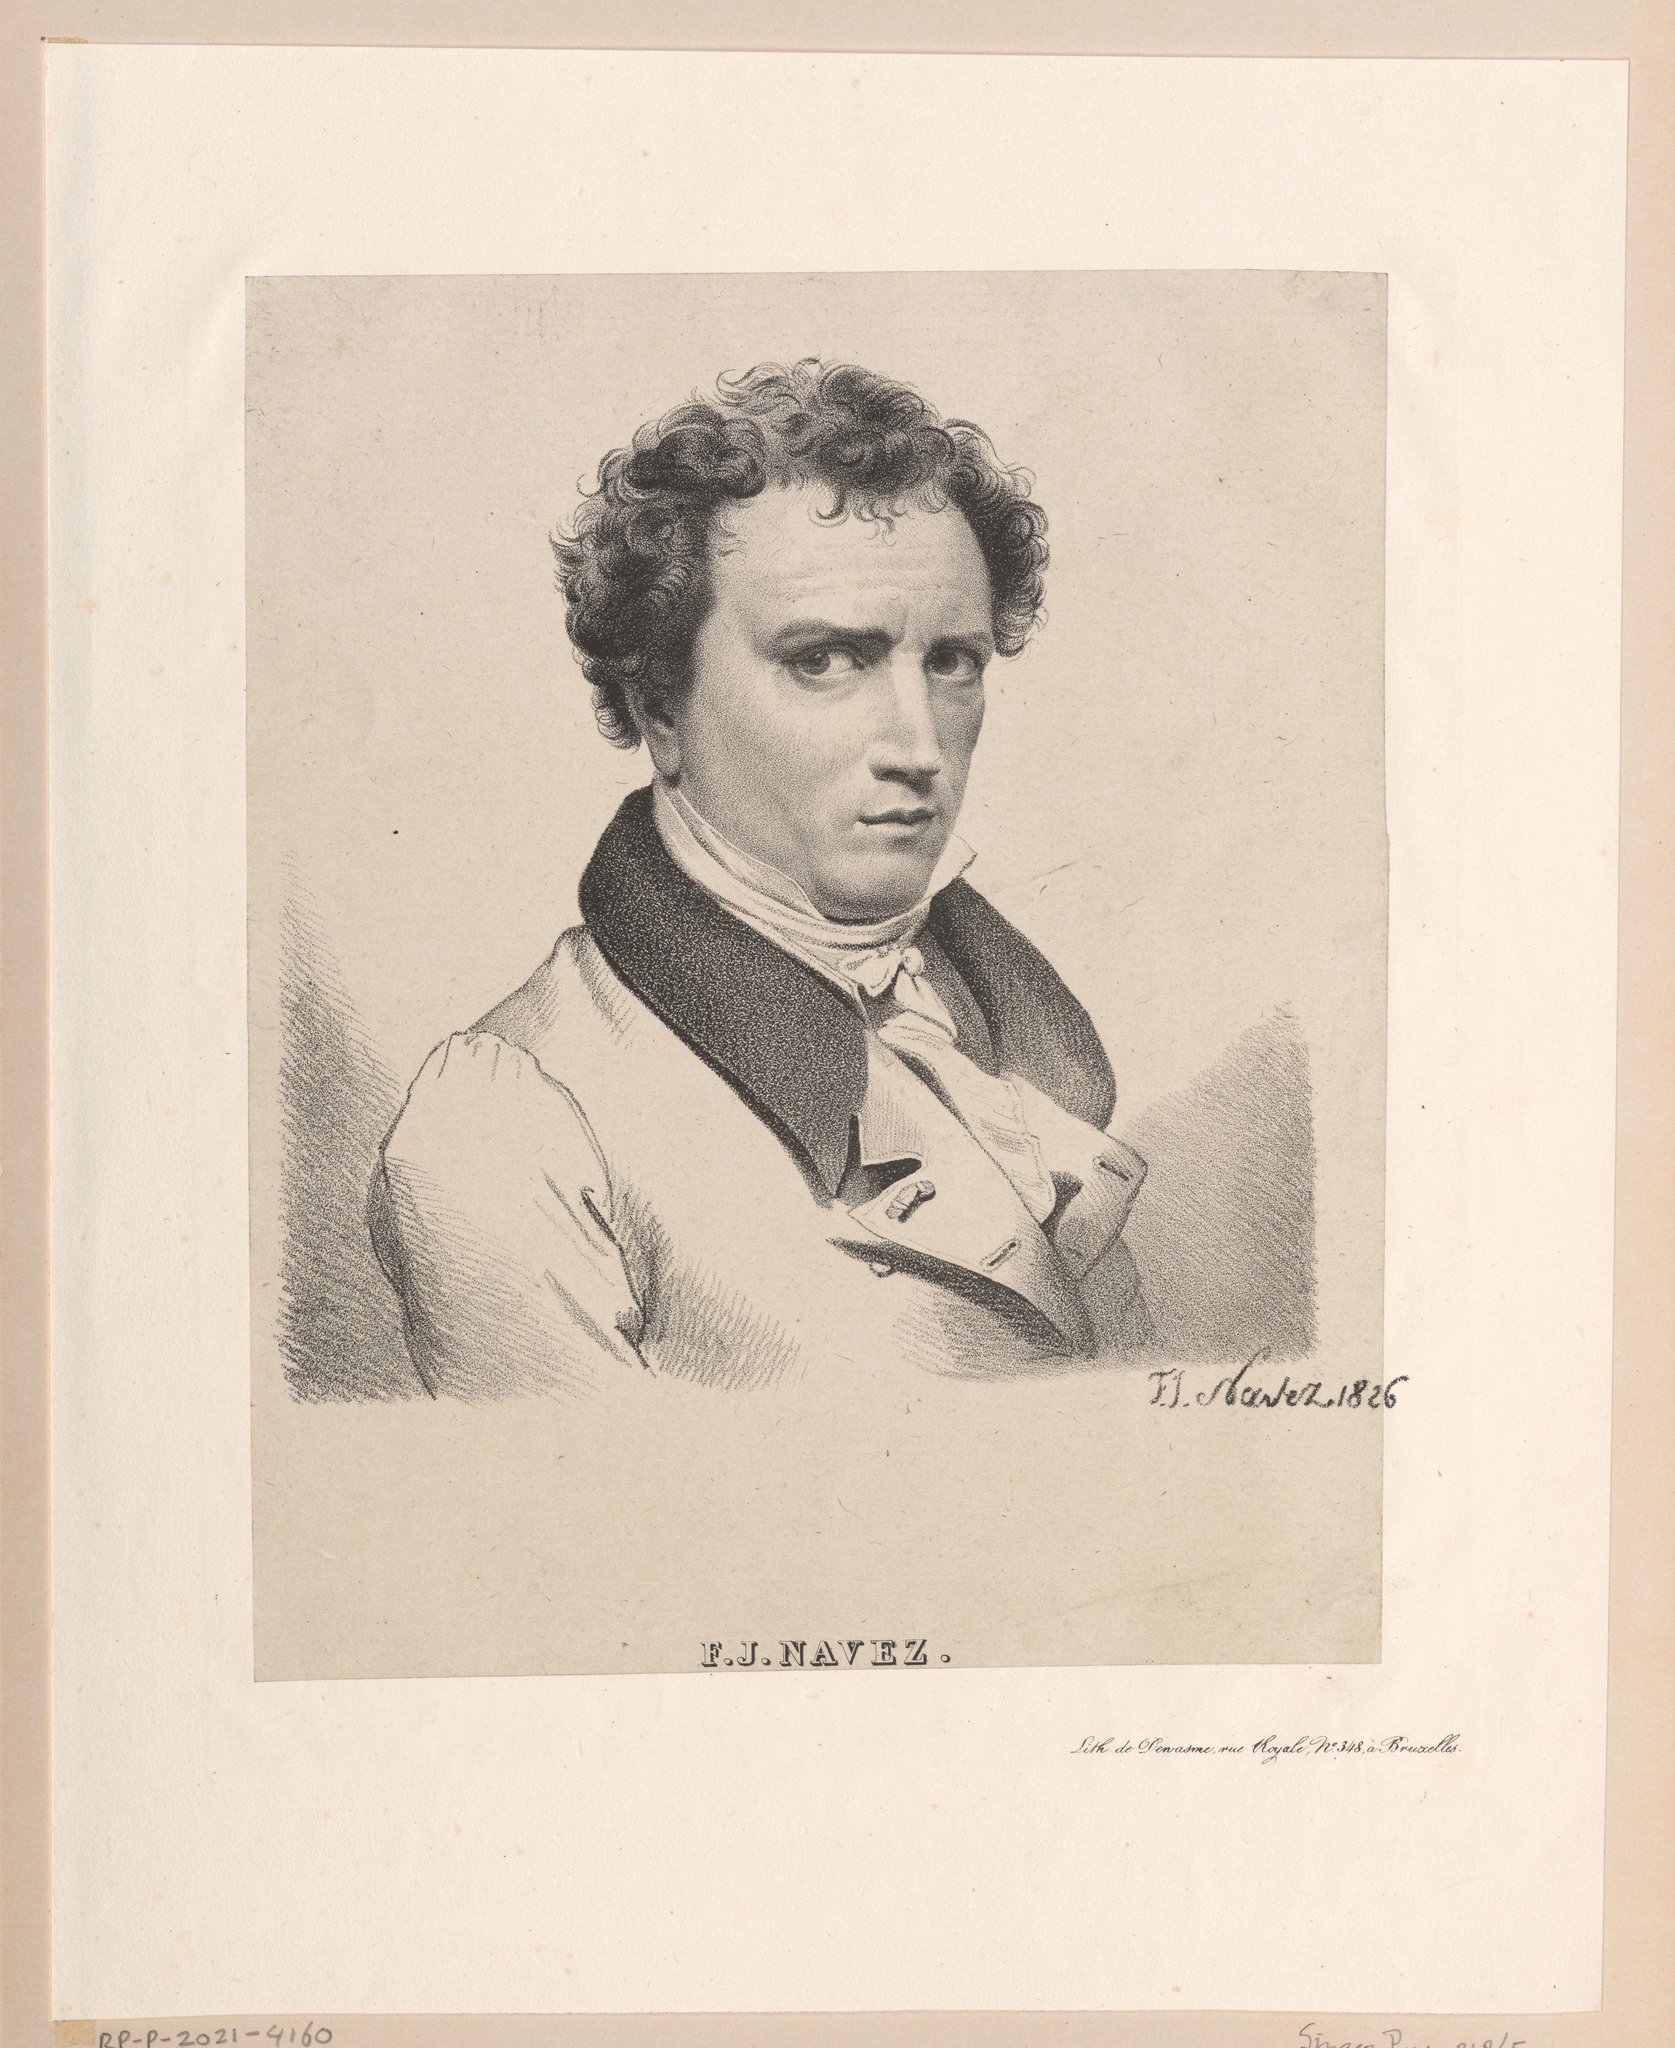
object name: print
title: Portret van François Joseph Navez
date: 1826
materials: paper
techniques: lithograph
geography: brussels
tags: brussels, painter, print maker, draughtsman, françois joseph navez, historical persons, portrait, self-portrait of painter